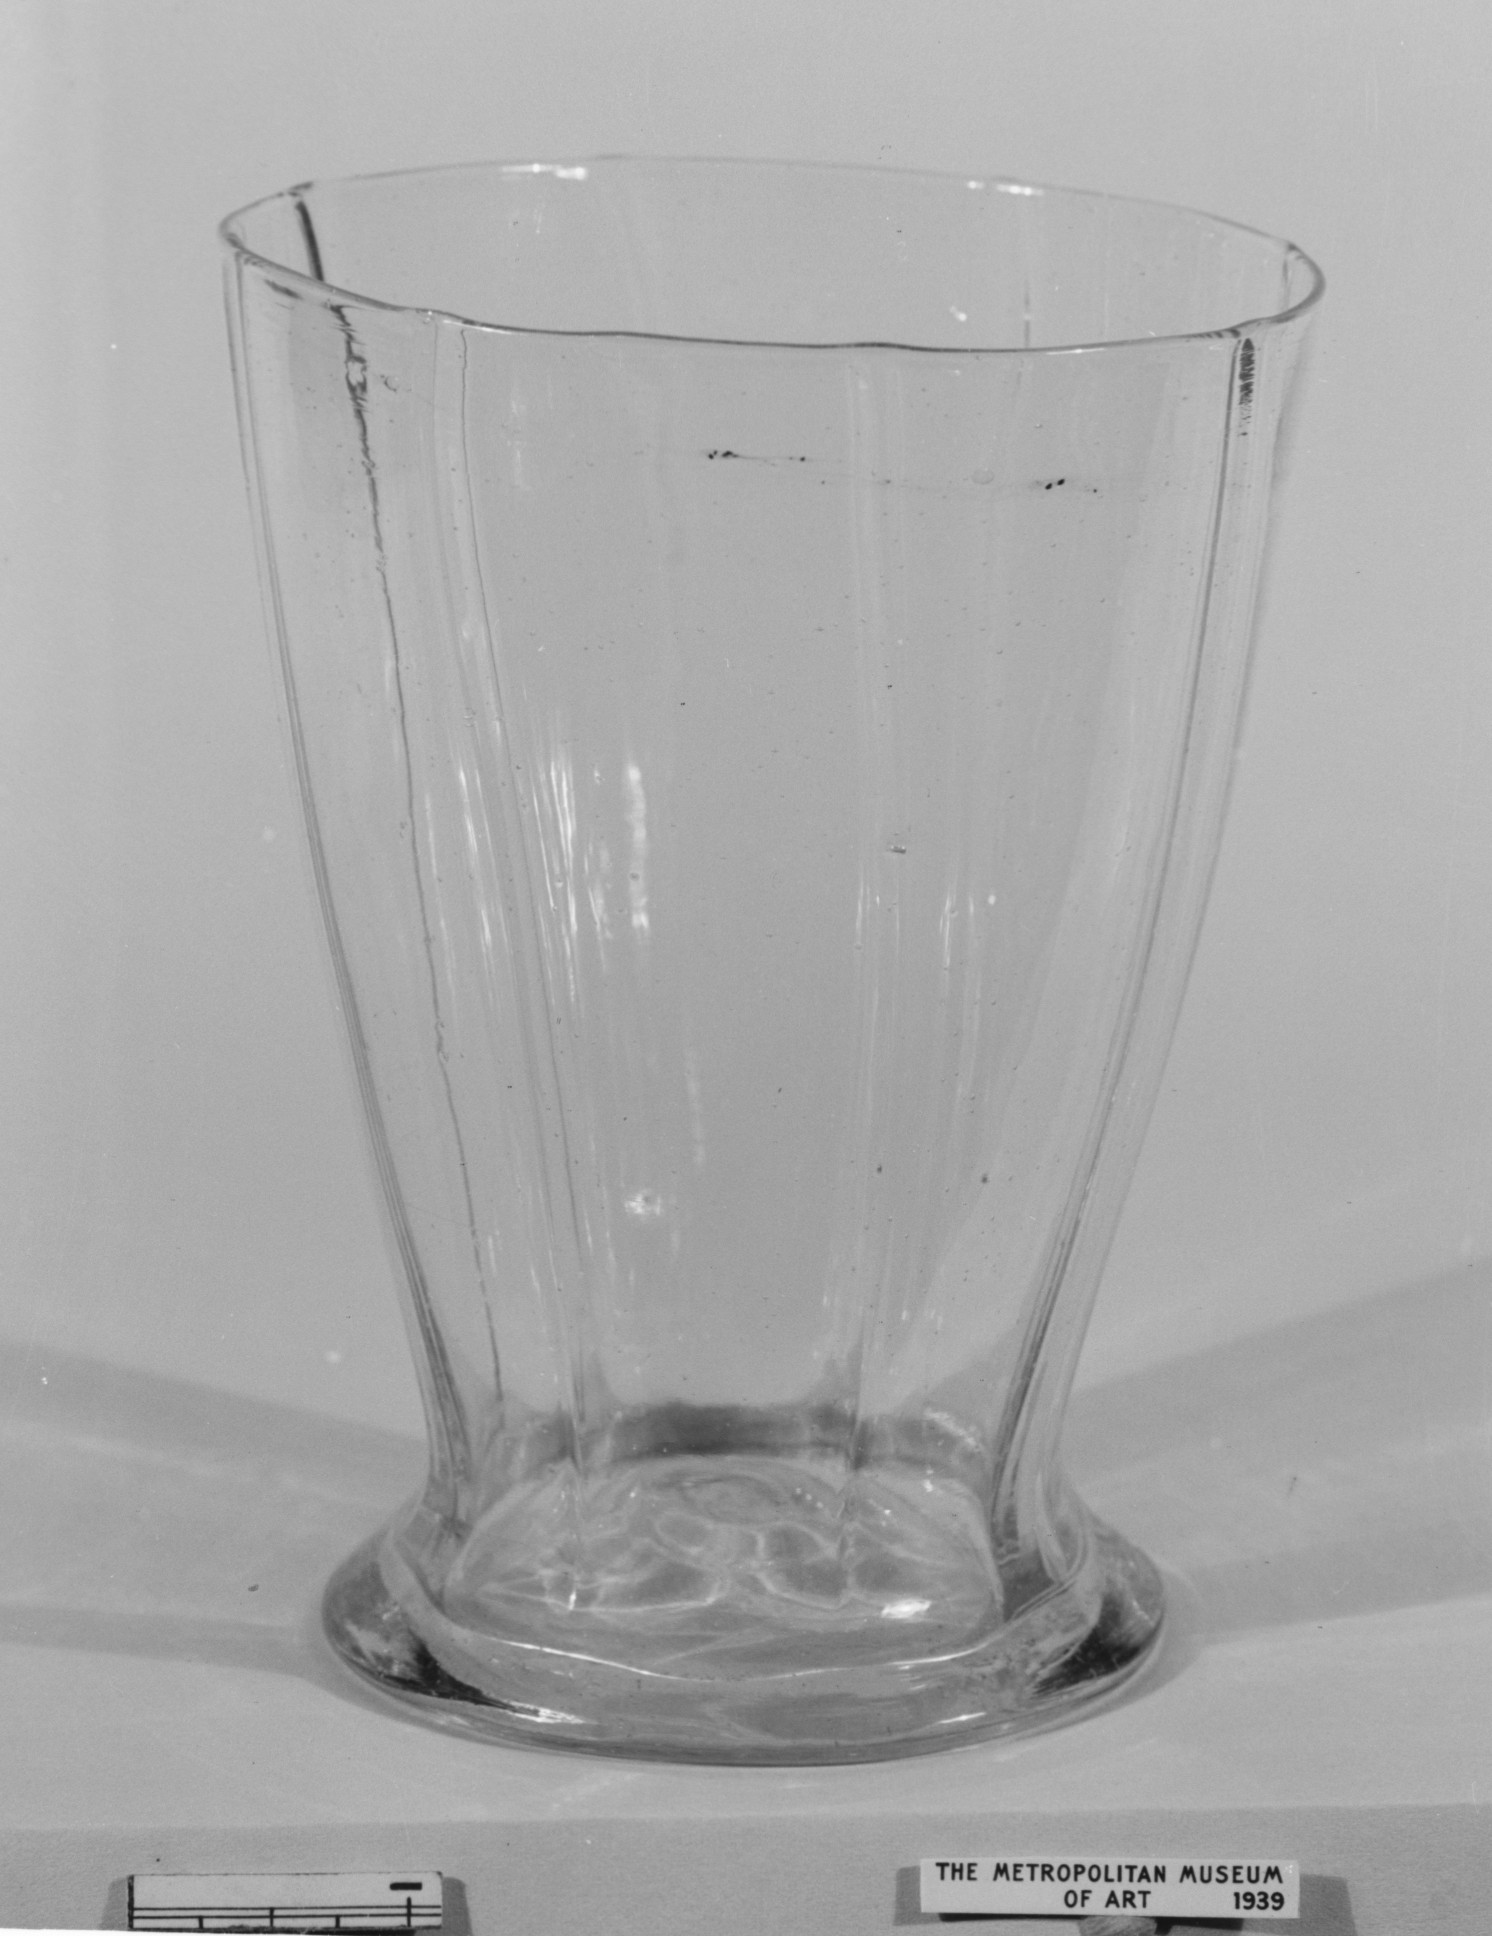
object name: beaker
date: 1601-1700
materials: glass